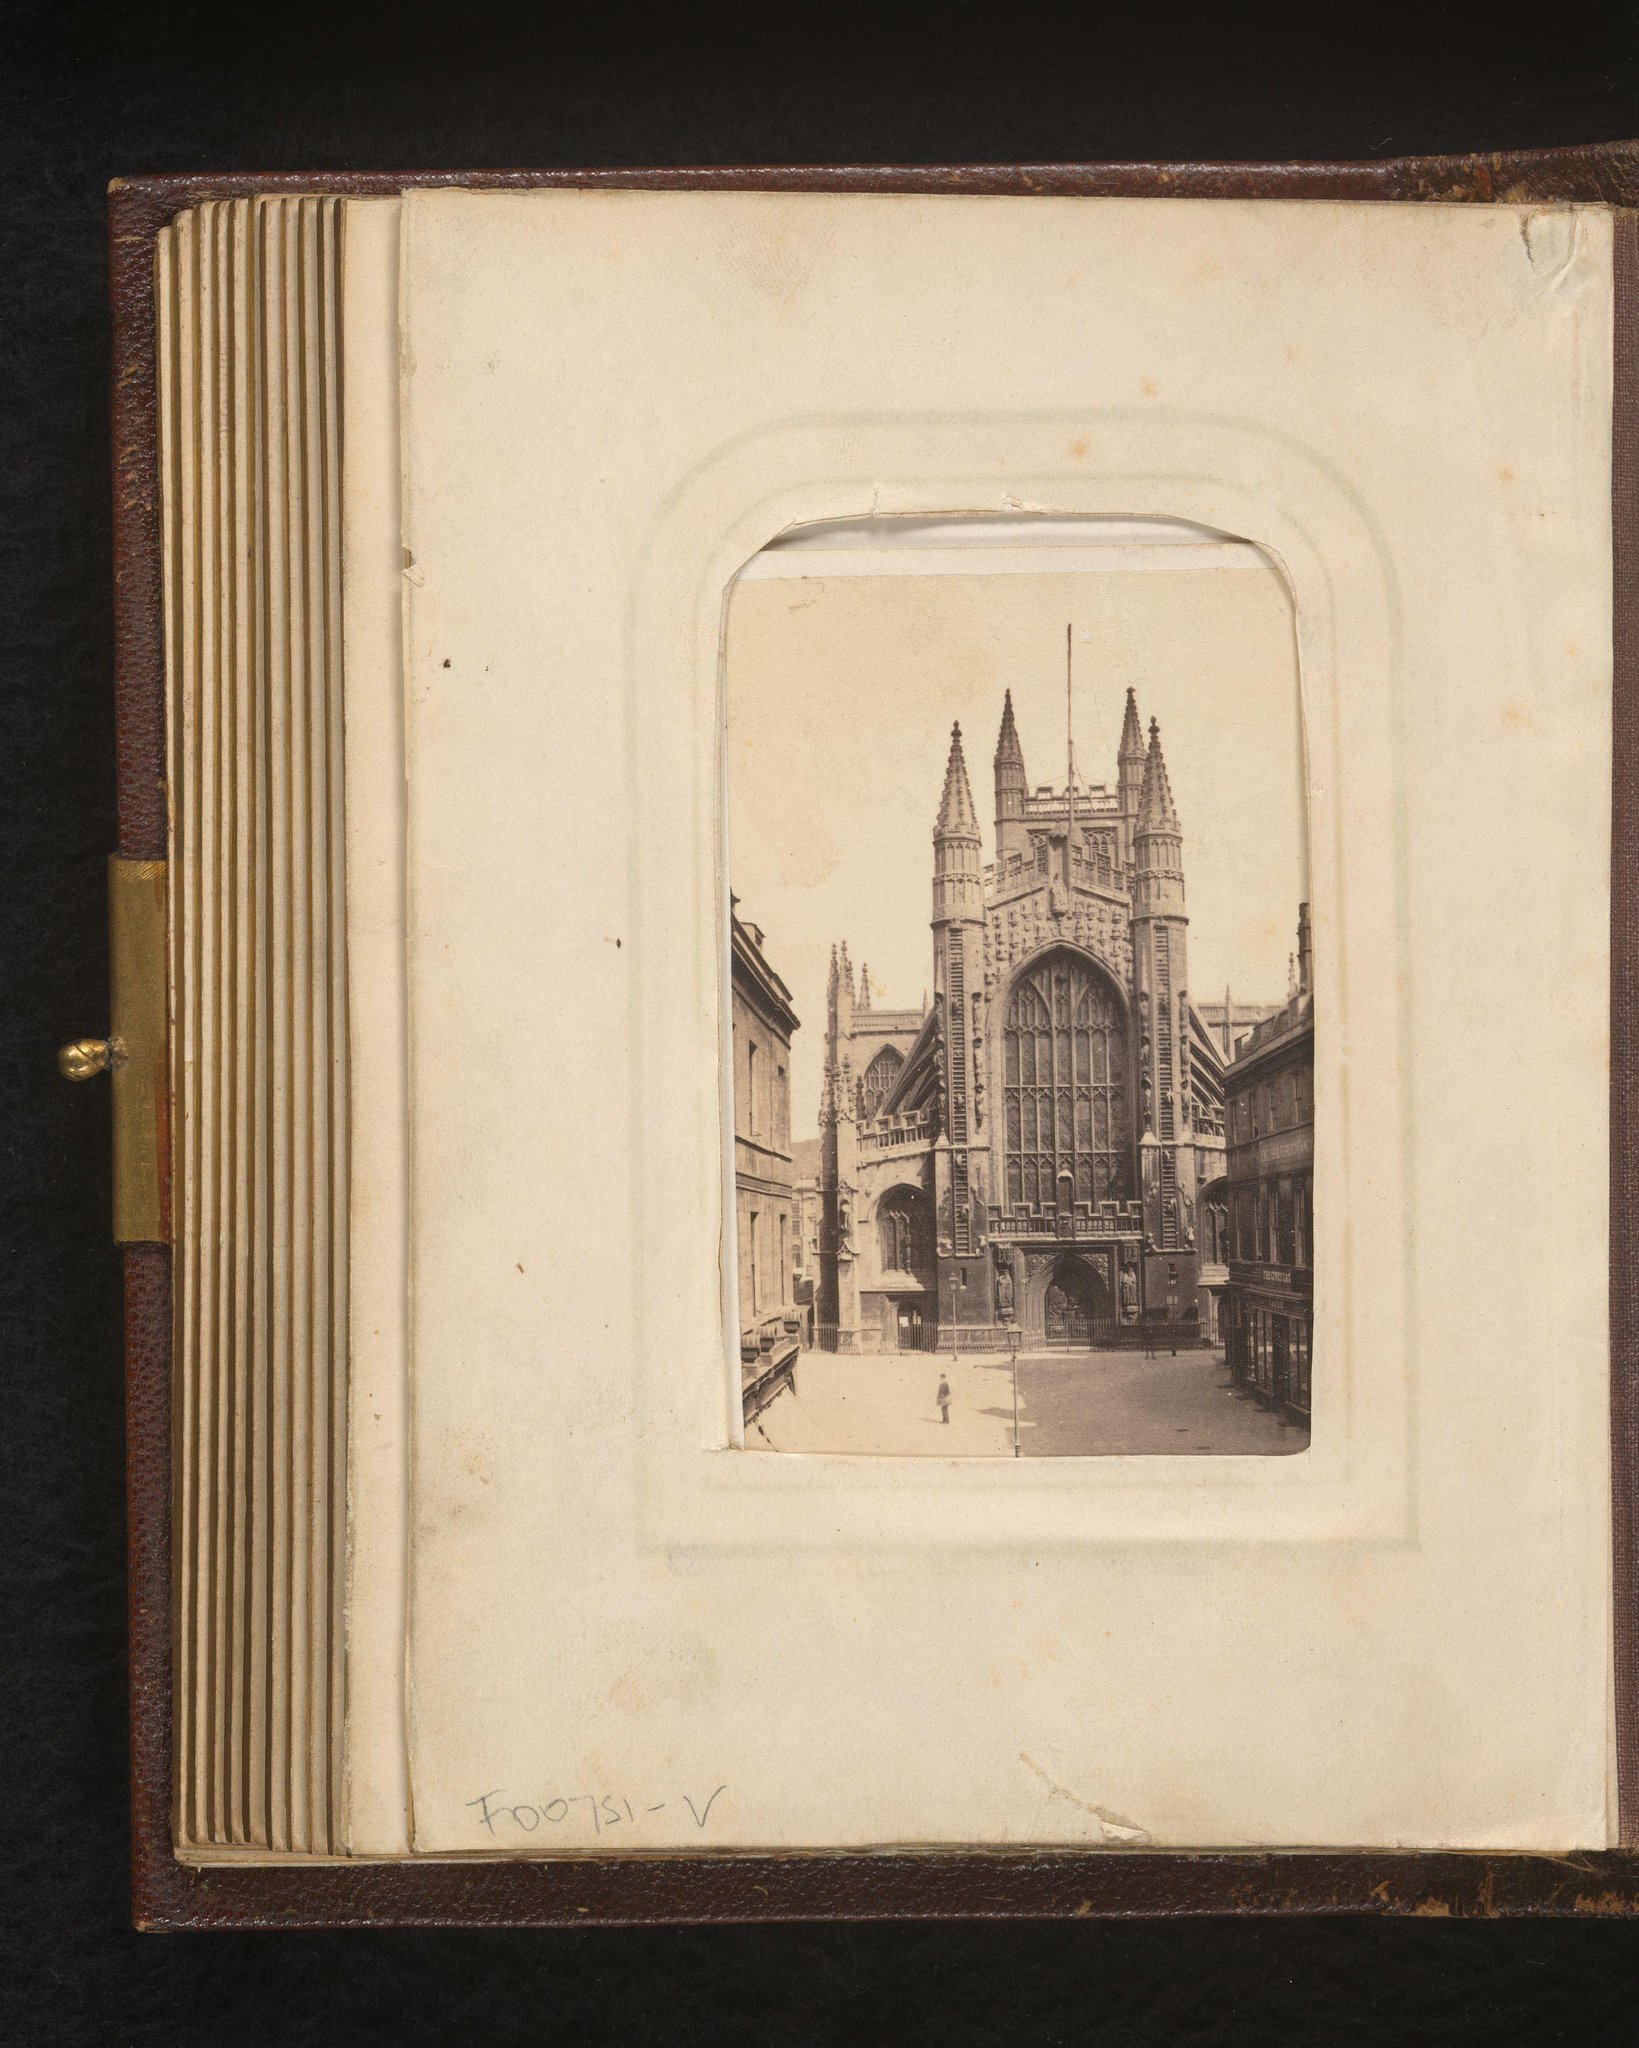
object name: album leaf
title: Bath Abbey te Bath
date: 1860-1900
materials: cardboard, photographic support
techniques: albumen print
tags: church (exterior)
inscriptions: inscription: ‘J & J Dutton/ late Dawson and Dutton/ 44, Milsom St./ Bath’, annotation: ‘300. Bath Abbey’